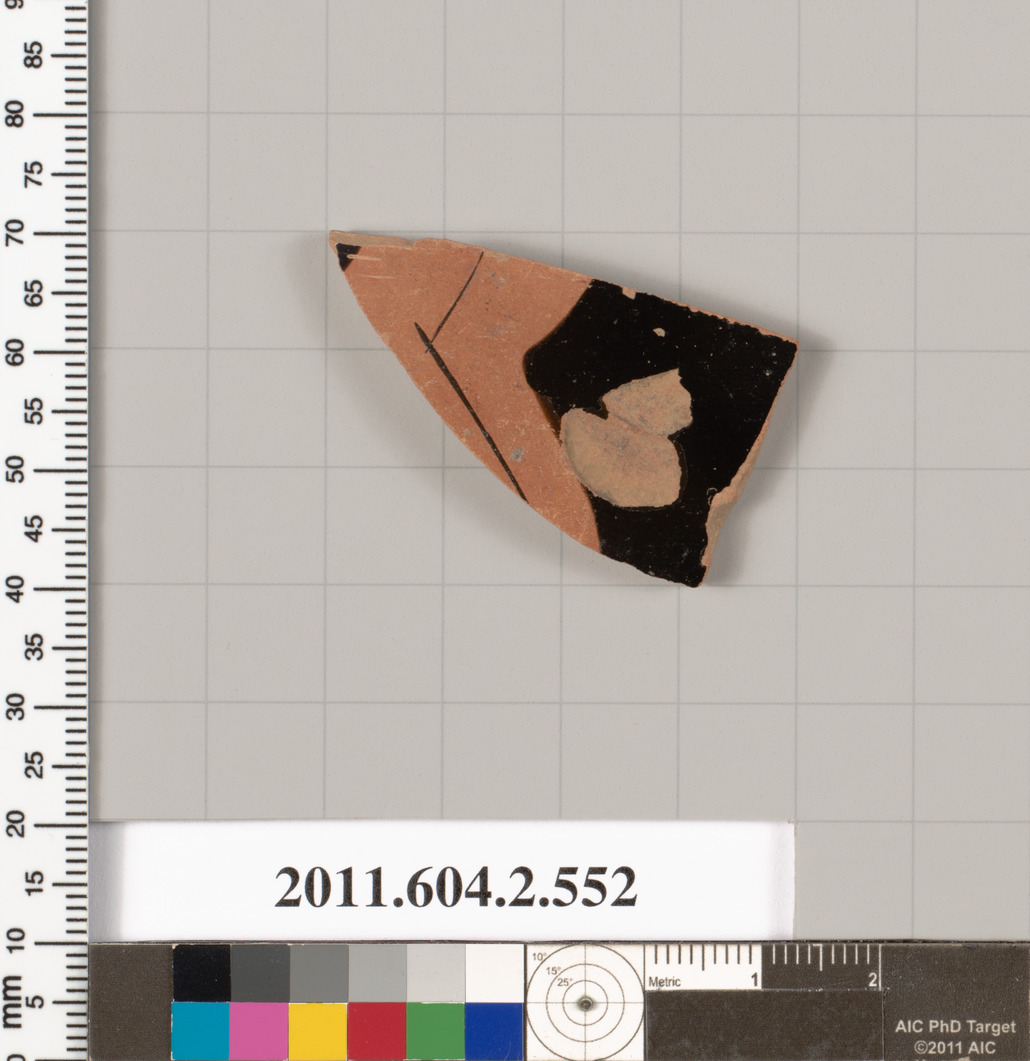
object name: column krater fragment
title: Terracotta fragment of a column-krater (bowl for mixing wine and water)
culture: greek, attic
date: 460-440 BCE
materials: terracotta